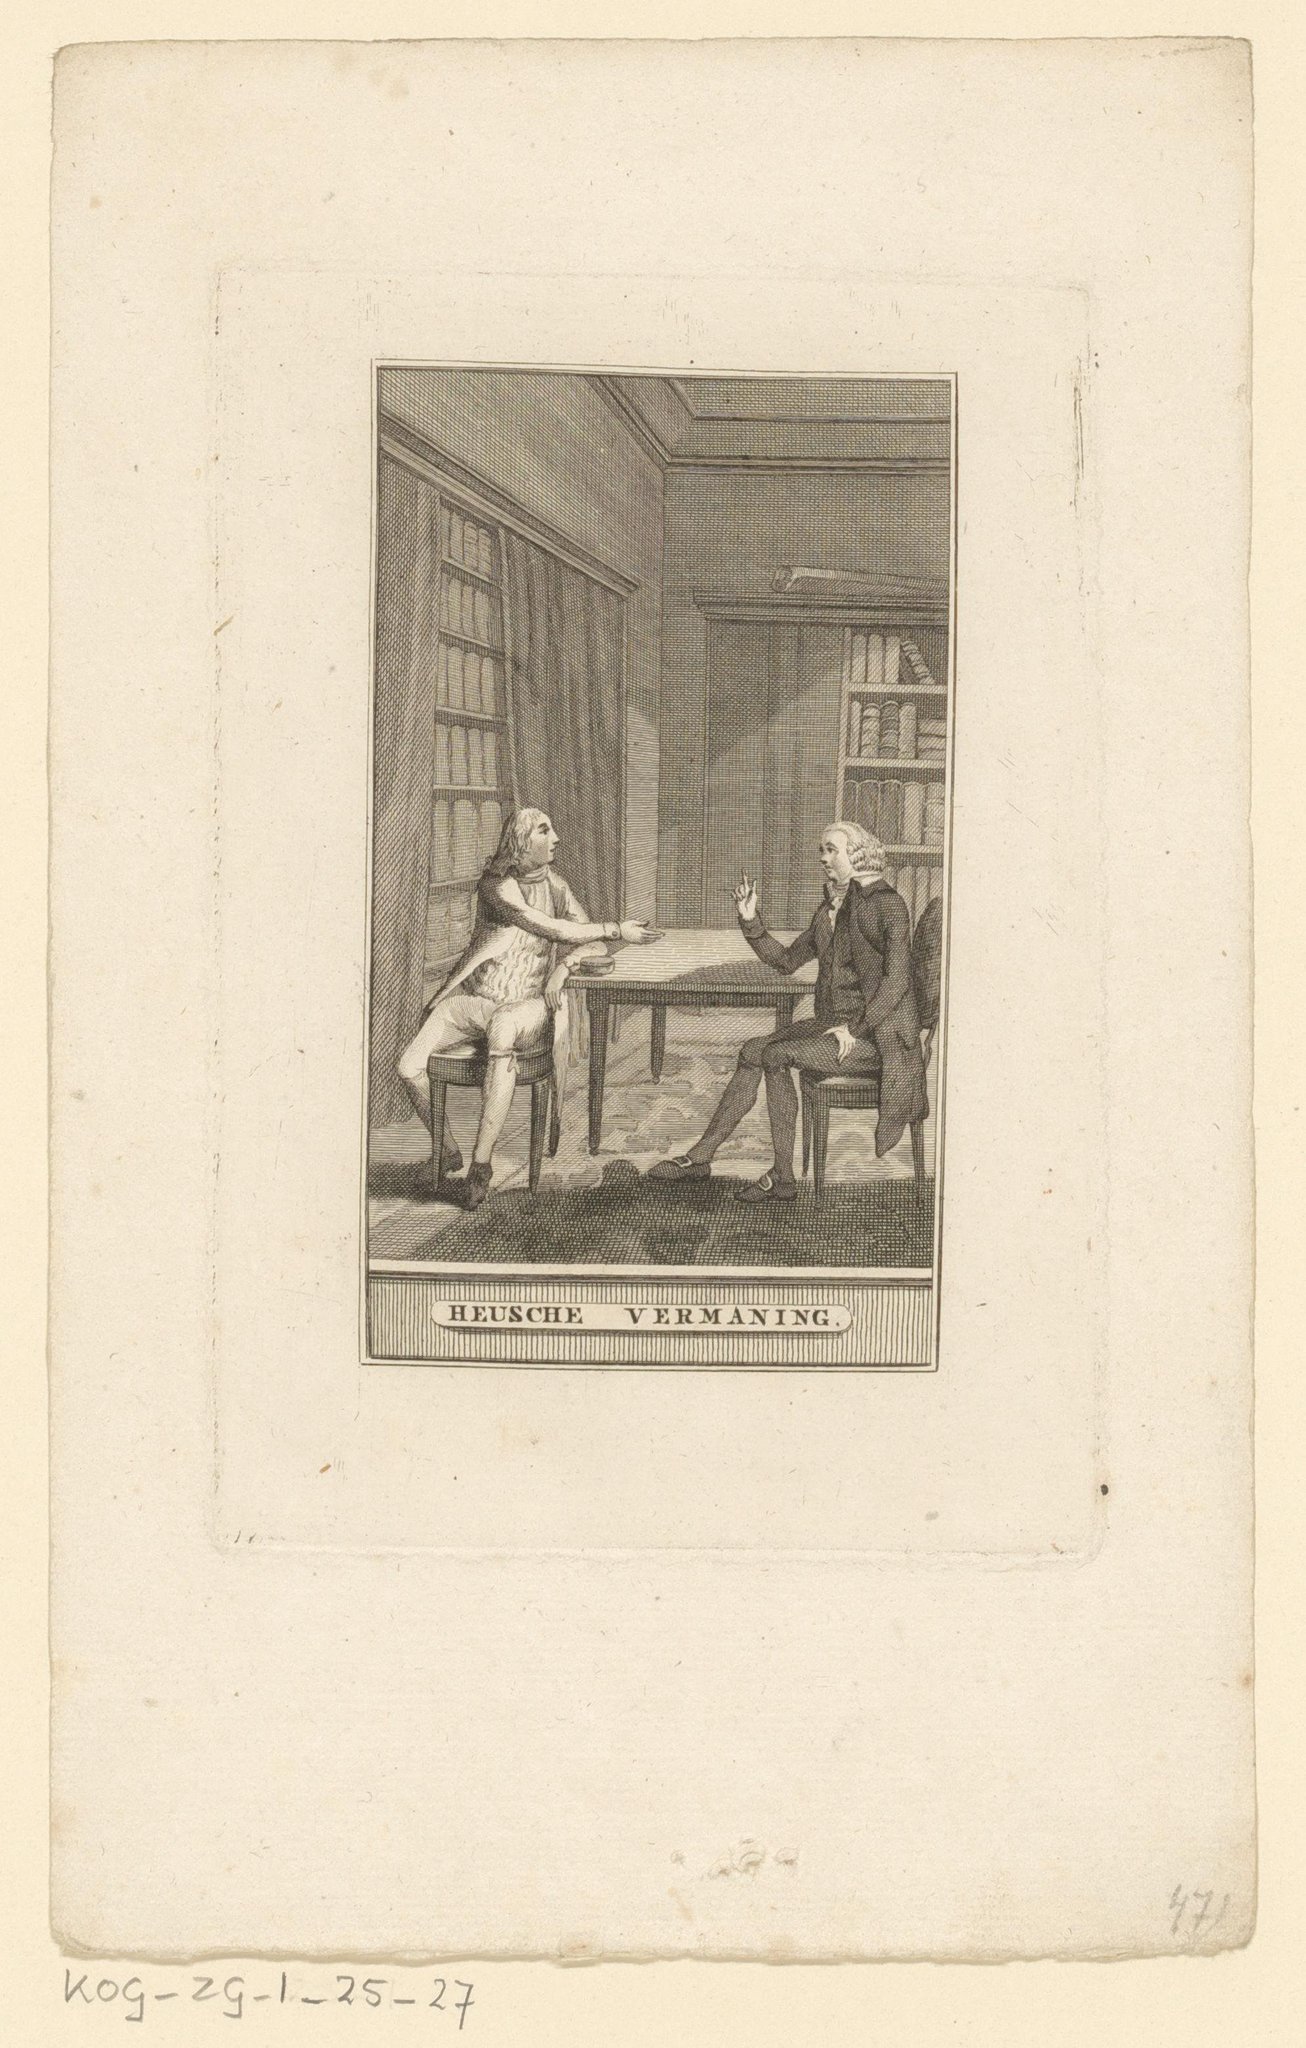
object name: print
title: Heusche vermaning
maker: Anonymous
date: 1798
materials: paper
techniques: etching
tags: negative criticism, study; 'studiolo'; library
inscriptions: stamp, collector's mark: Lugt 1641, stamp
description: Onderwerpsrubrieken binnen de Atlas Zeden en Gewoonten: Zeden en Gewoonten in Engeren Zin, De Woning, Binnenhuizen, Boekerijen.